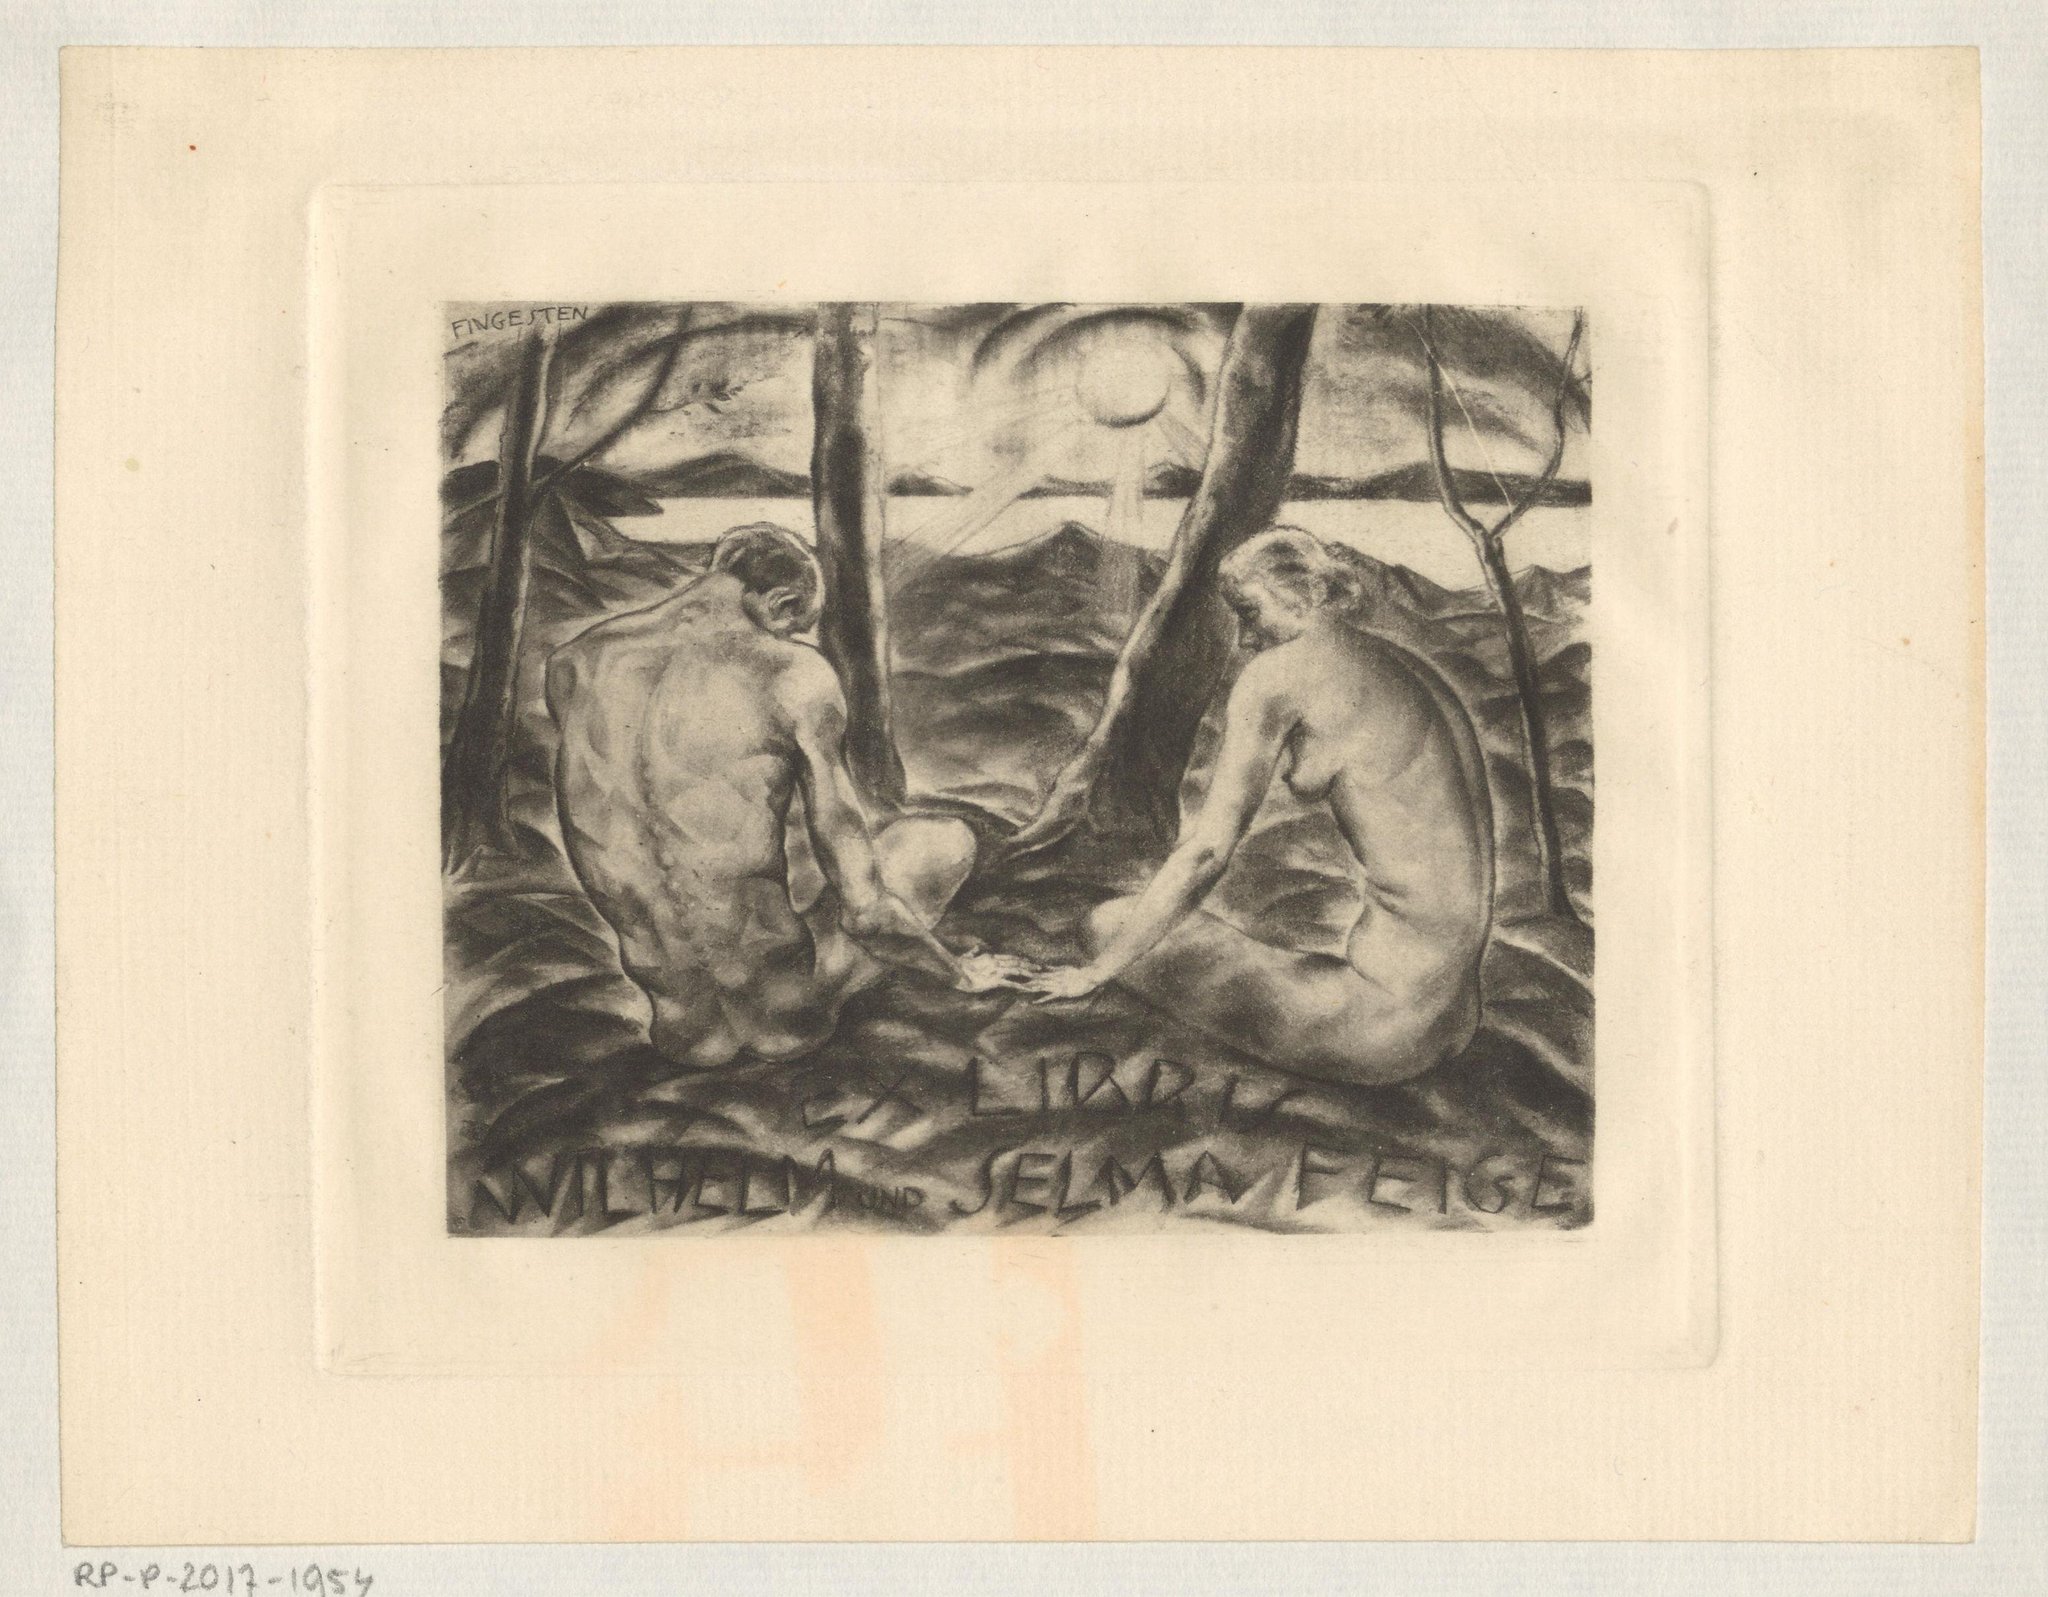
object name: photomechanical print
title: Ex libris van Wilhelm en Selma Feige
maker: Anonymous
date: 1894-1943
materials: paper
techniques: photograph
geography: italy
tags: woman (showing herself) undressed, quasi-nude, forest, wood, sunset, couple of lovers, man (showing himself) undressed, quasi-nude